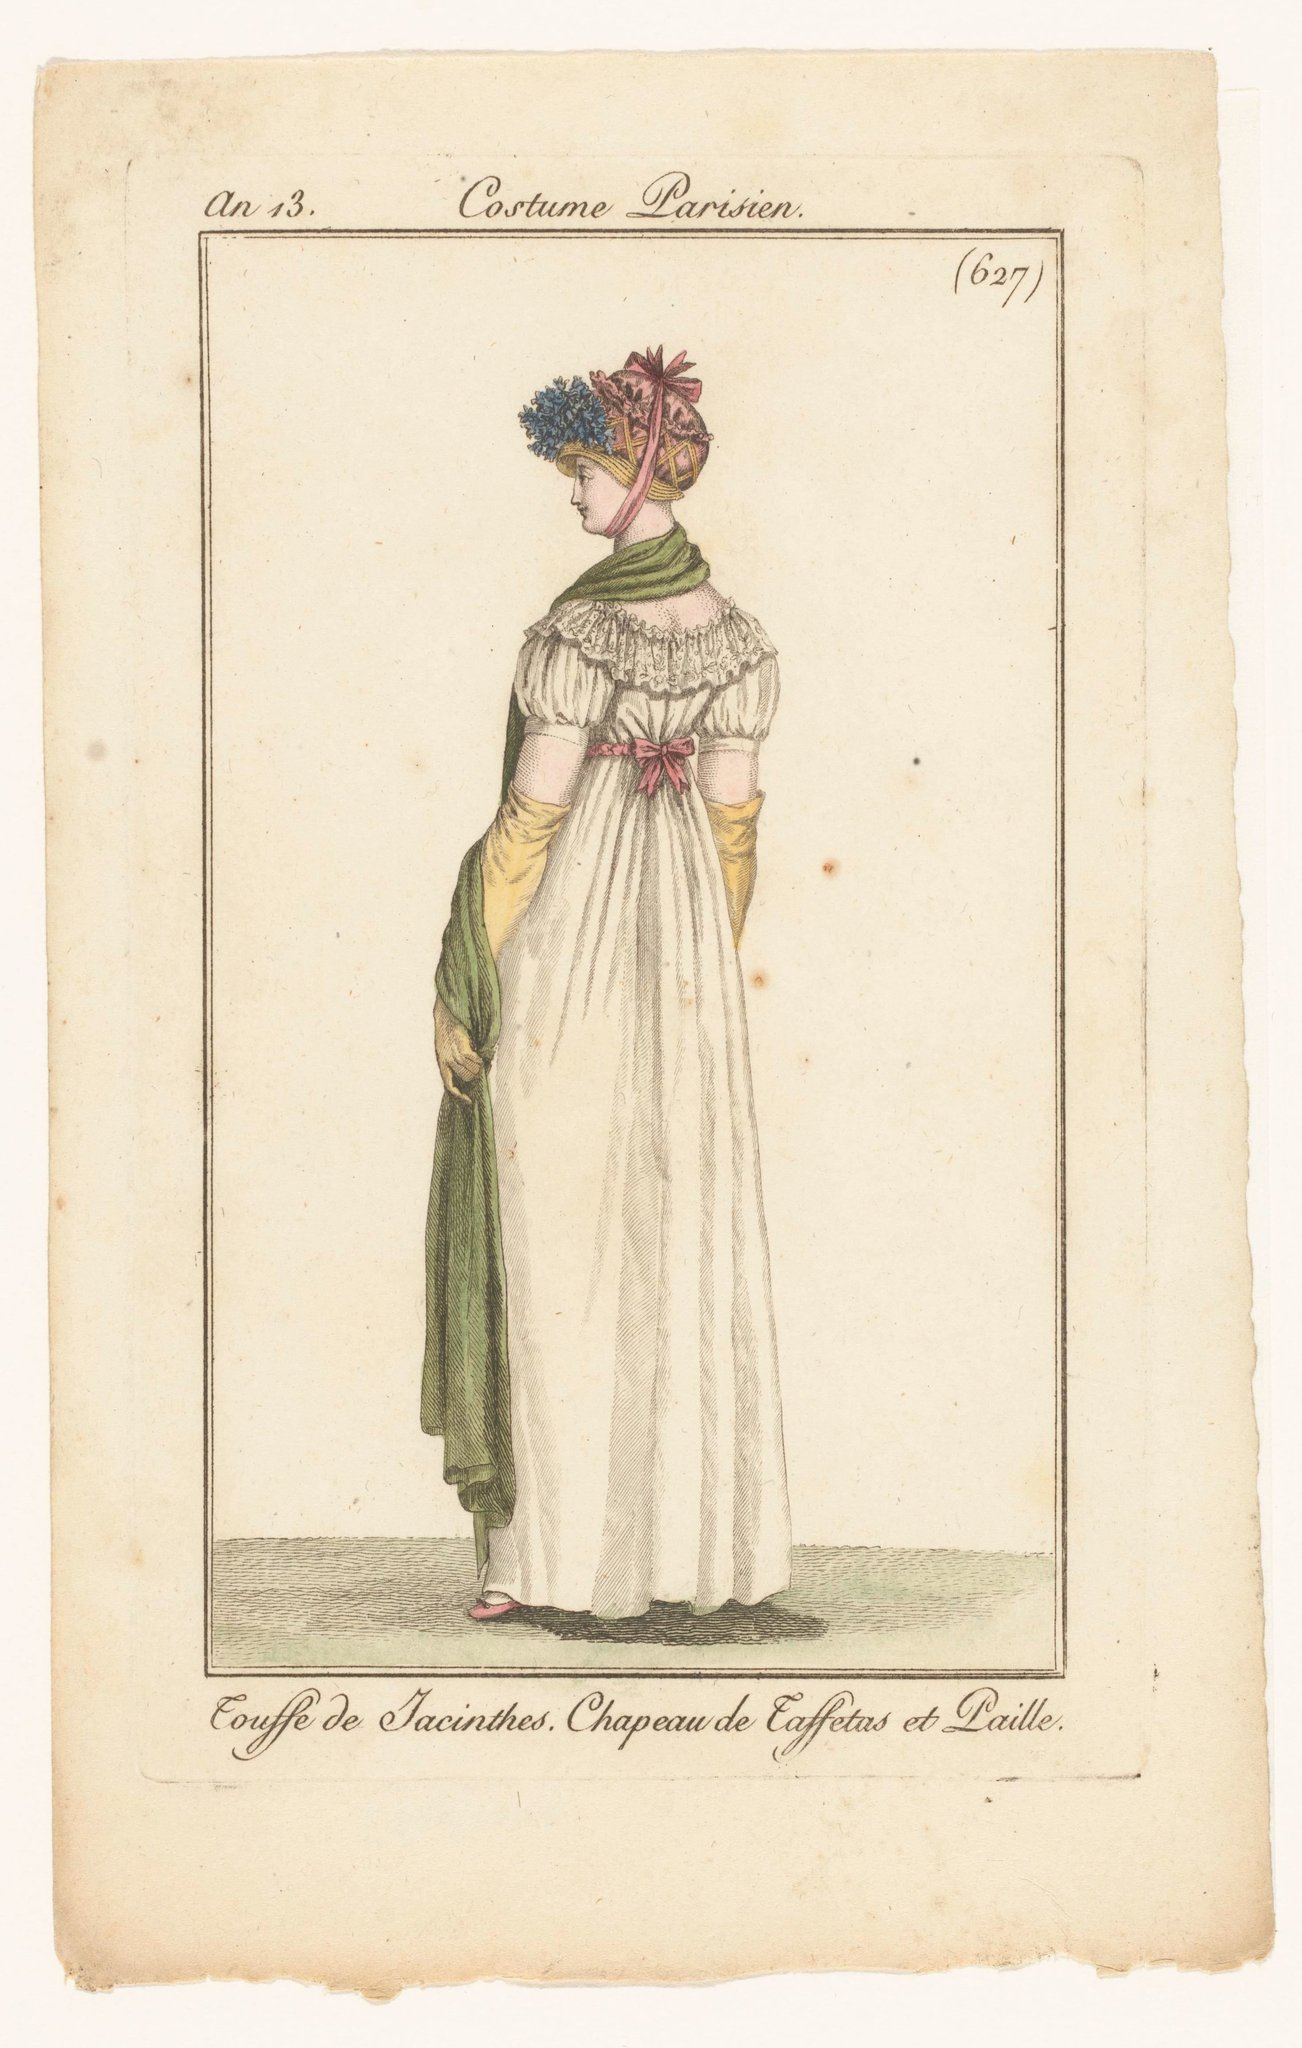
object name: fashion print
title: Journal des Dames et des modes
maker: Anonymous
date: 1804-1805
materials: paper, ink, watercolor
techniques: etching, hand coloring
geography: europe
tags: fashion plates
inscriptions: collector's mark: Lugt 2228